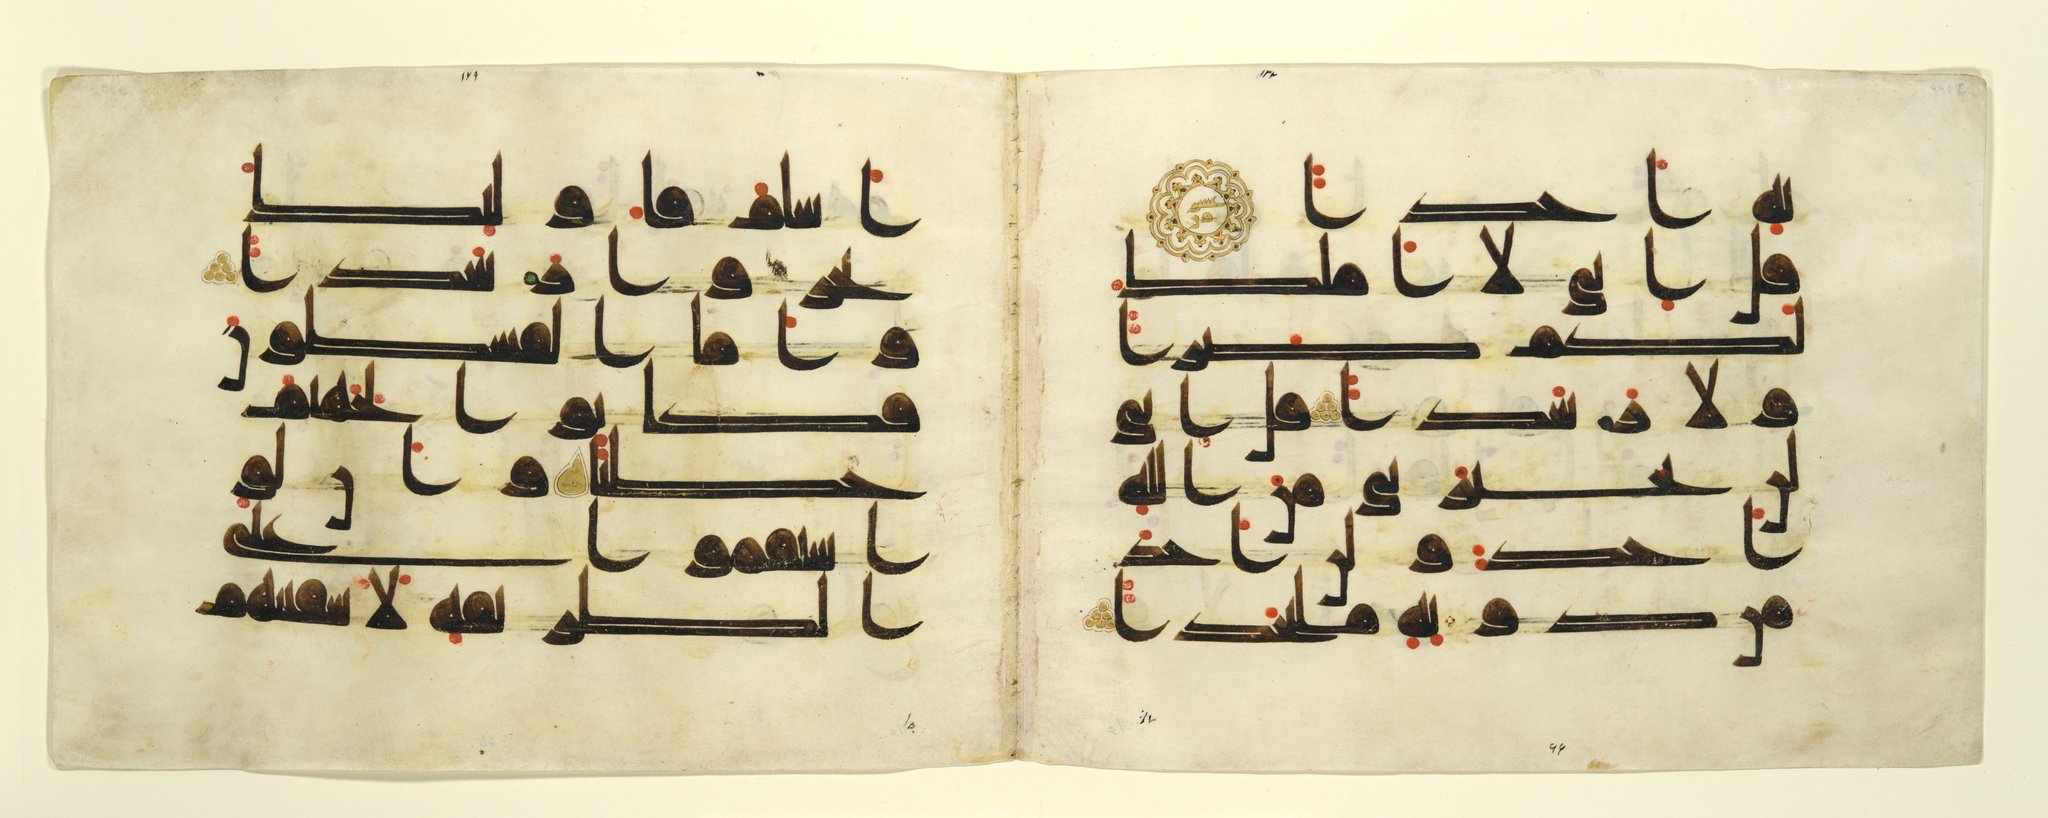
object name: bifolio from a non illustrated manuscript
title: Bifolium from a Qur'an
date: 867-1000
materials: gold, ink, parchment, watercolor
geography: central islamic lands or north africa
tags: arabic,qur'an,calligraphy